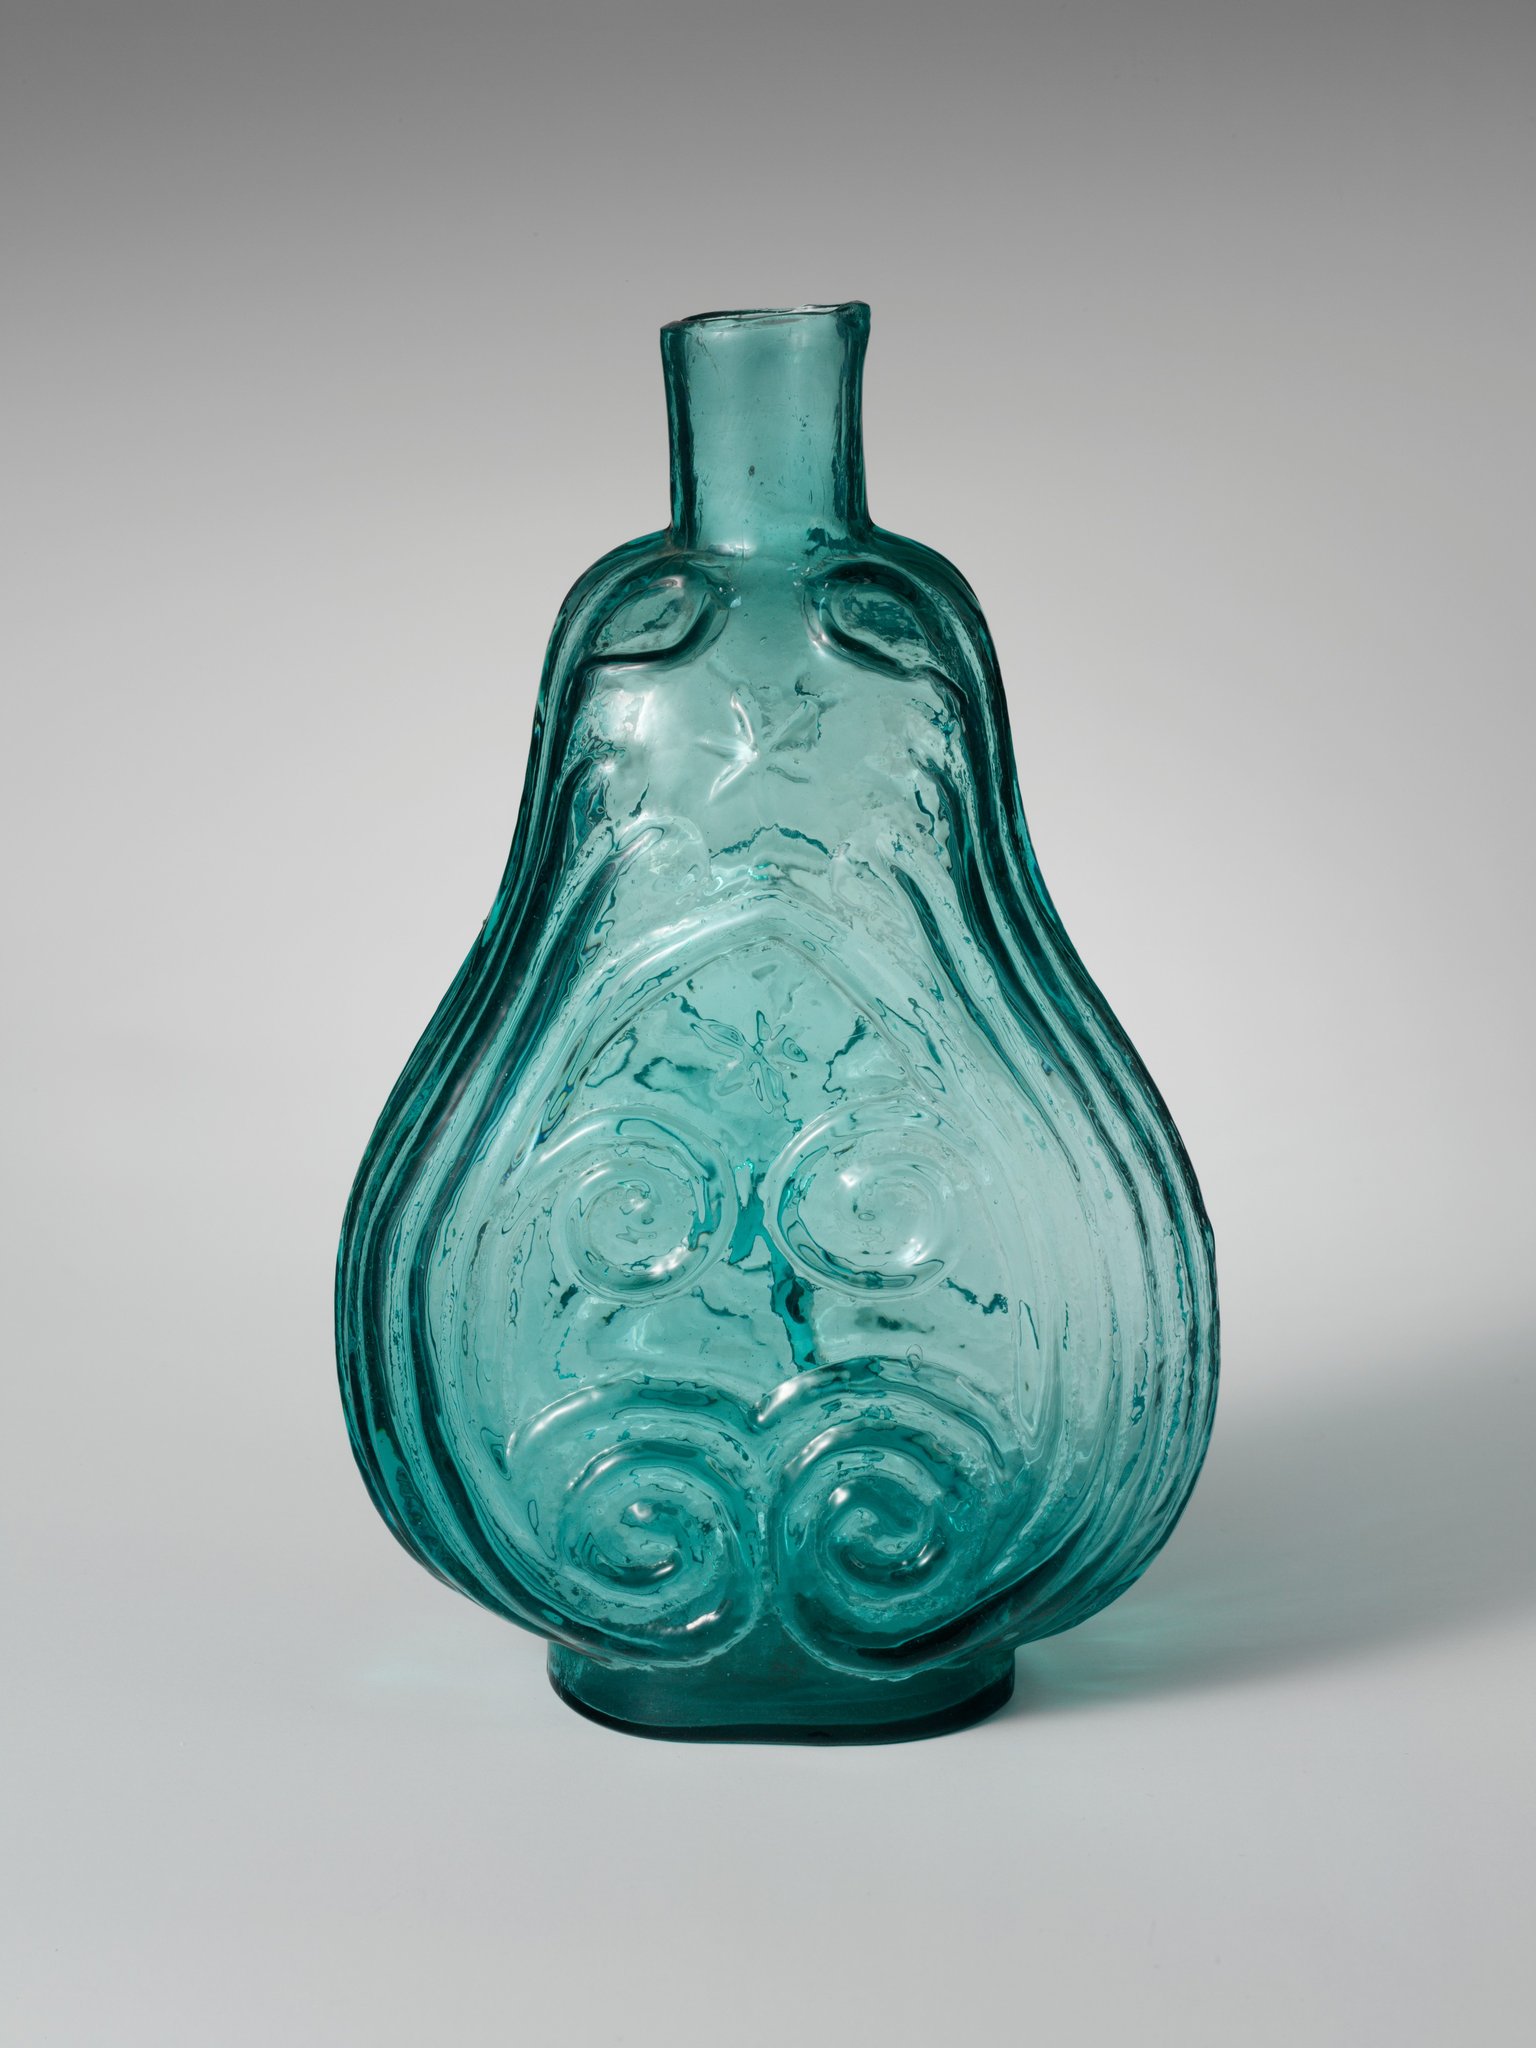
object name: flask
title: Scroll flask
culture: american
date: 1840-1850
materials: gemstone, glass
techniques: glassblowing, molding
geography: united states